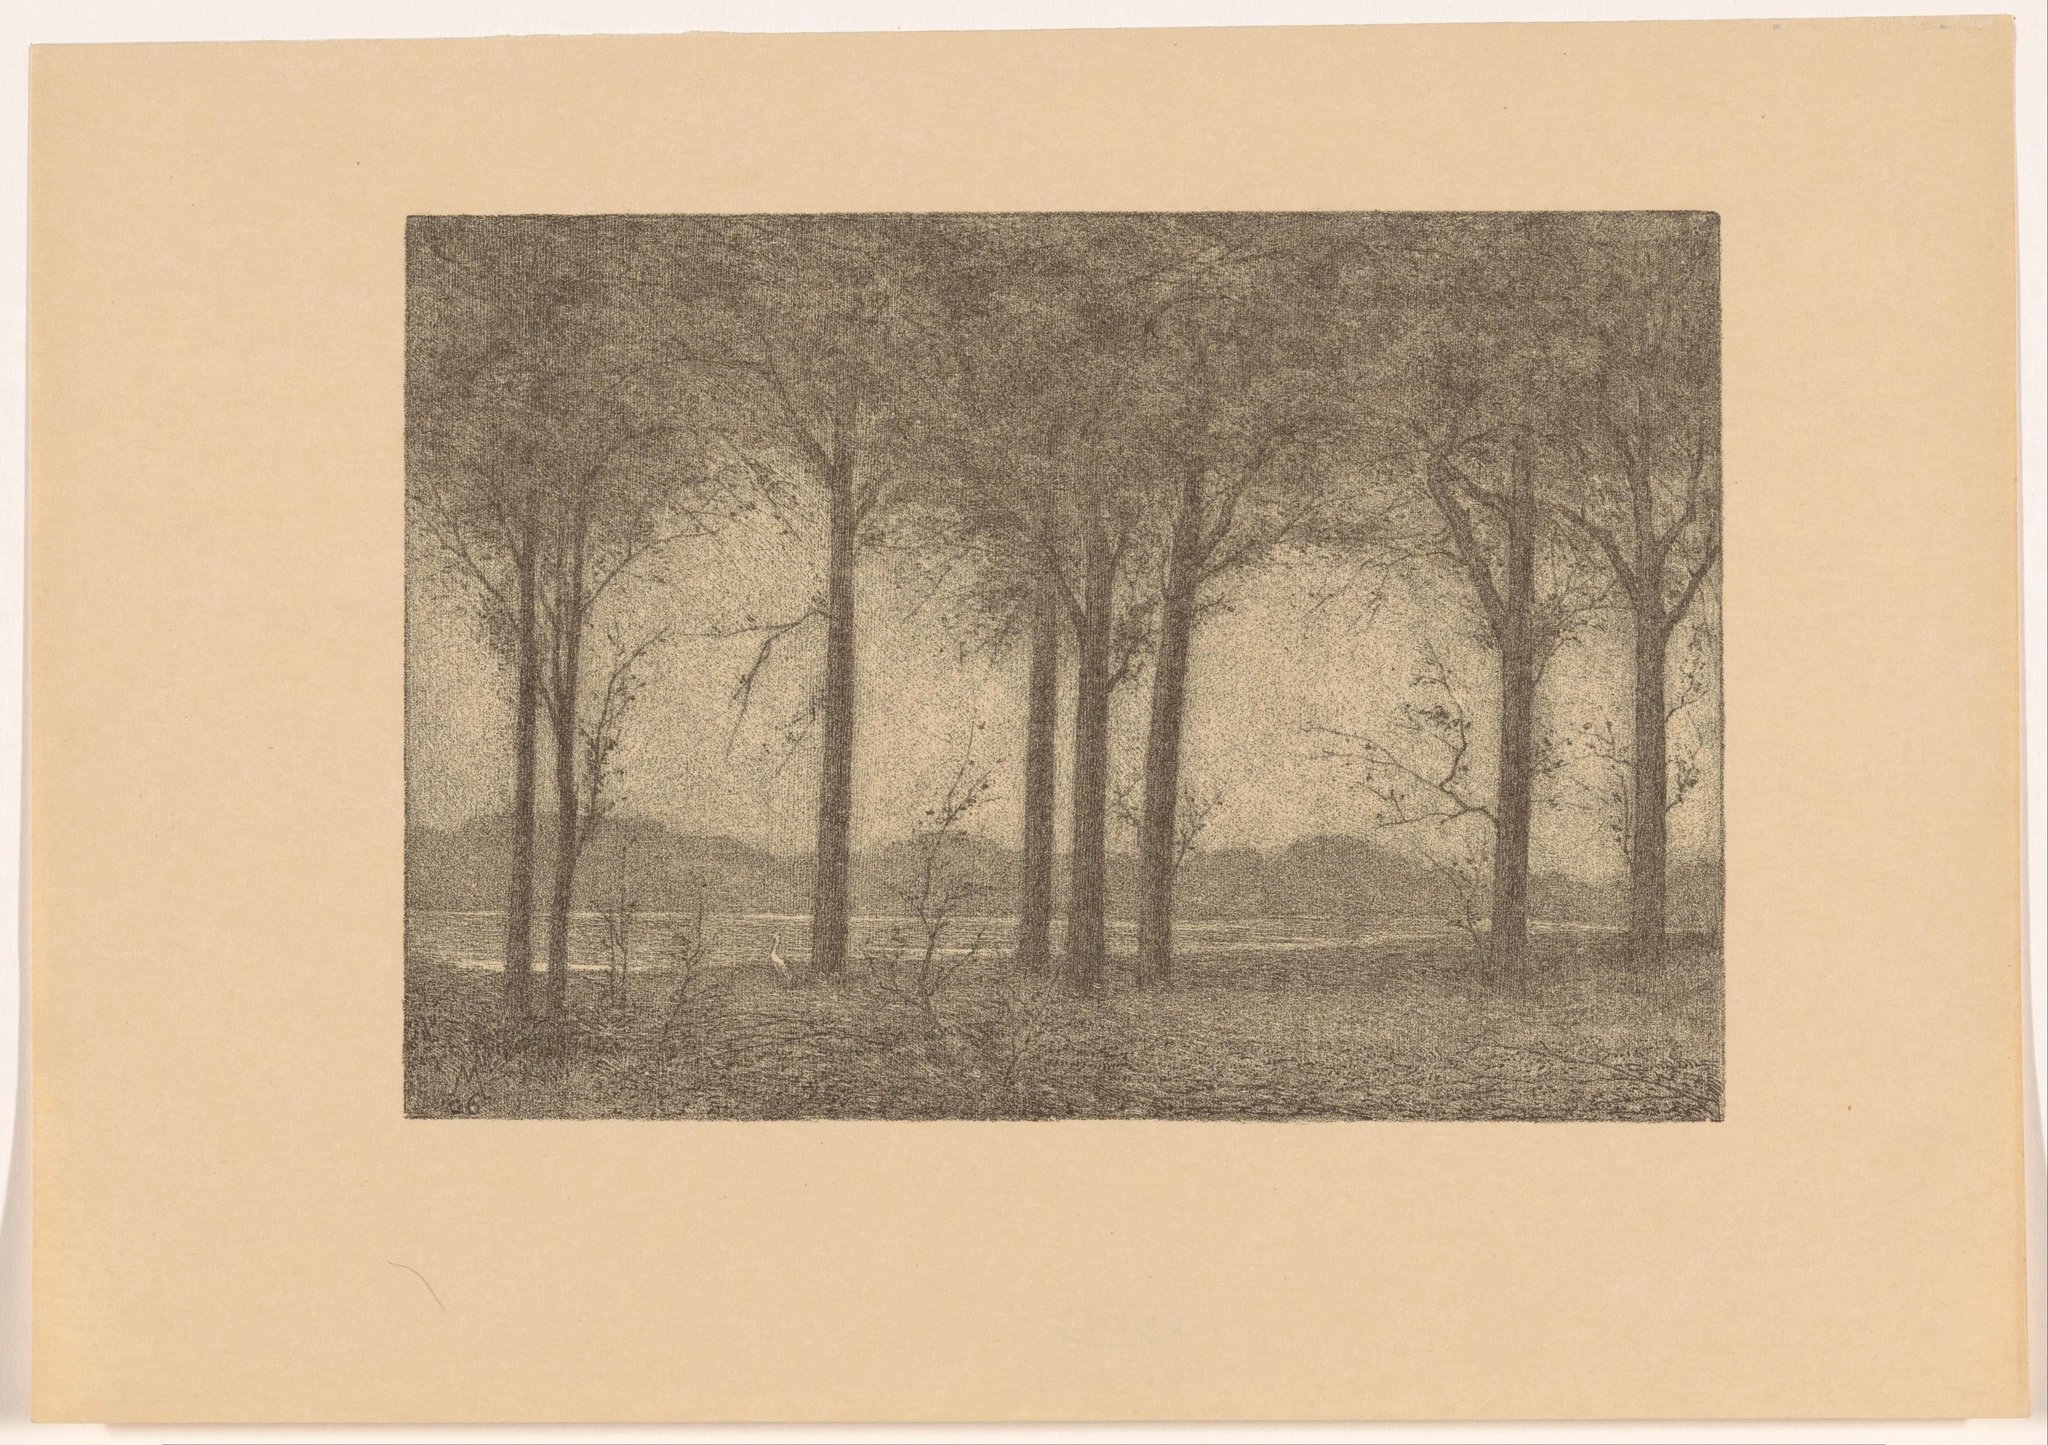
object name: print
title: Bomen aan het water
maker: simon moulijn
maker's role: draughtsman, print maker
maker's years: 1866-1948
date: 1906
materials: paper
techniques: lithograph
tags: trees, water course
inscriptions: collector's mark: Lugt 2228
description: Prent mogelijk gebruikt voor: Onze kunst. Geïllustreerd maandschrift voor beeldende en decoratieve kunsten. Antwerpen: Buschman, 1906, dl. IX.